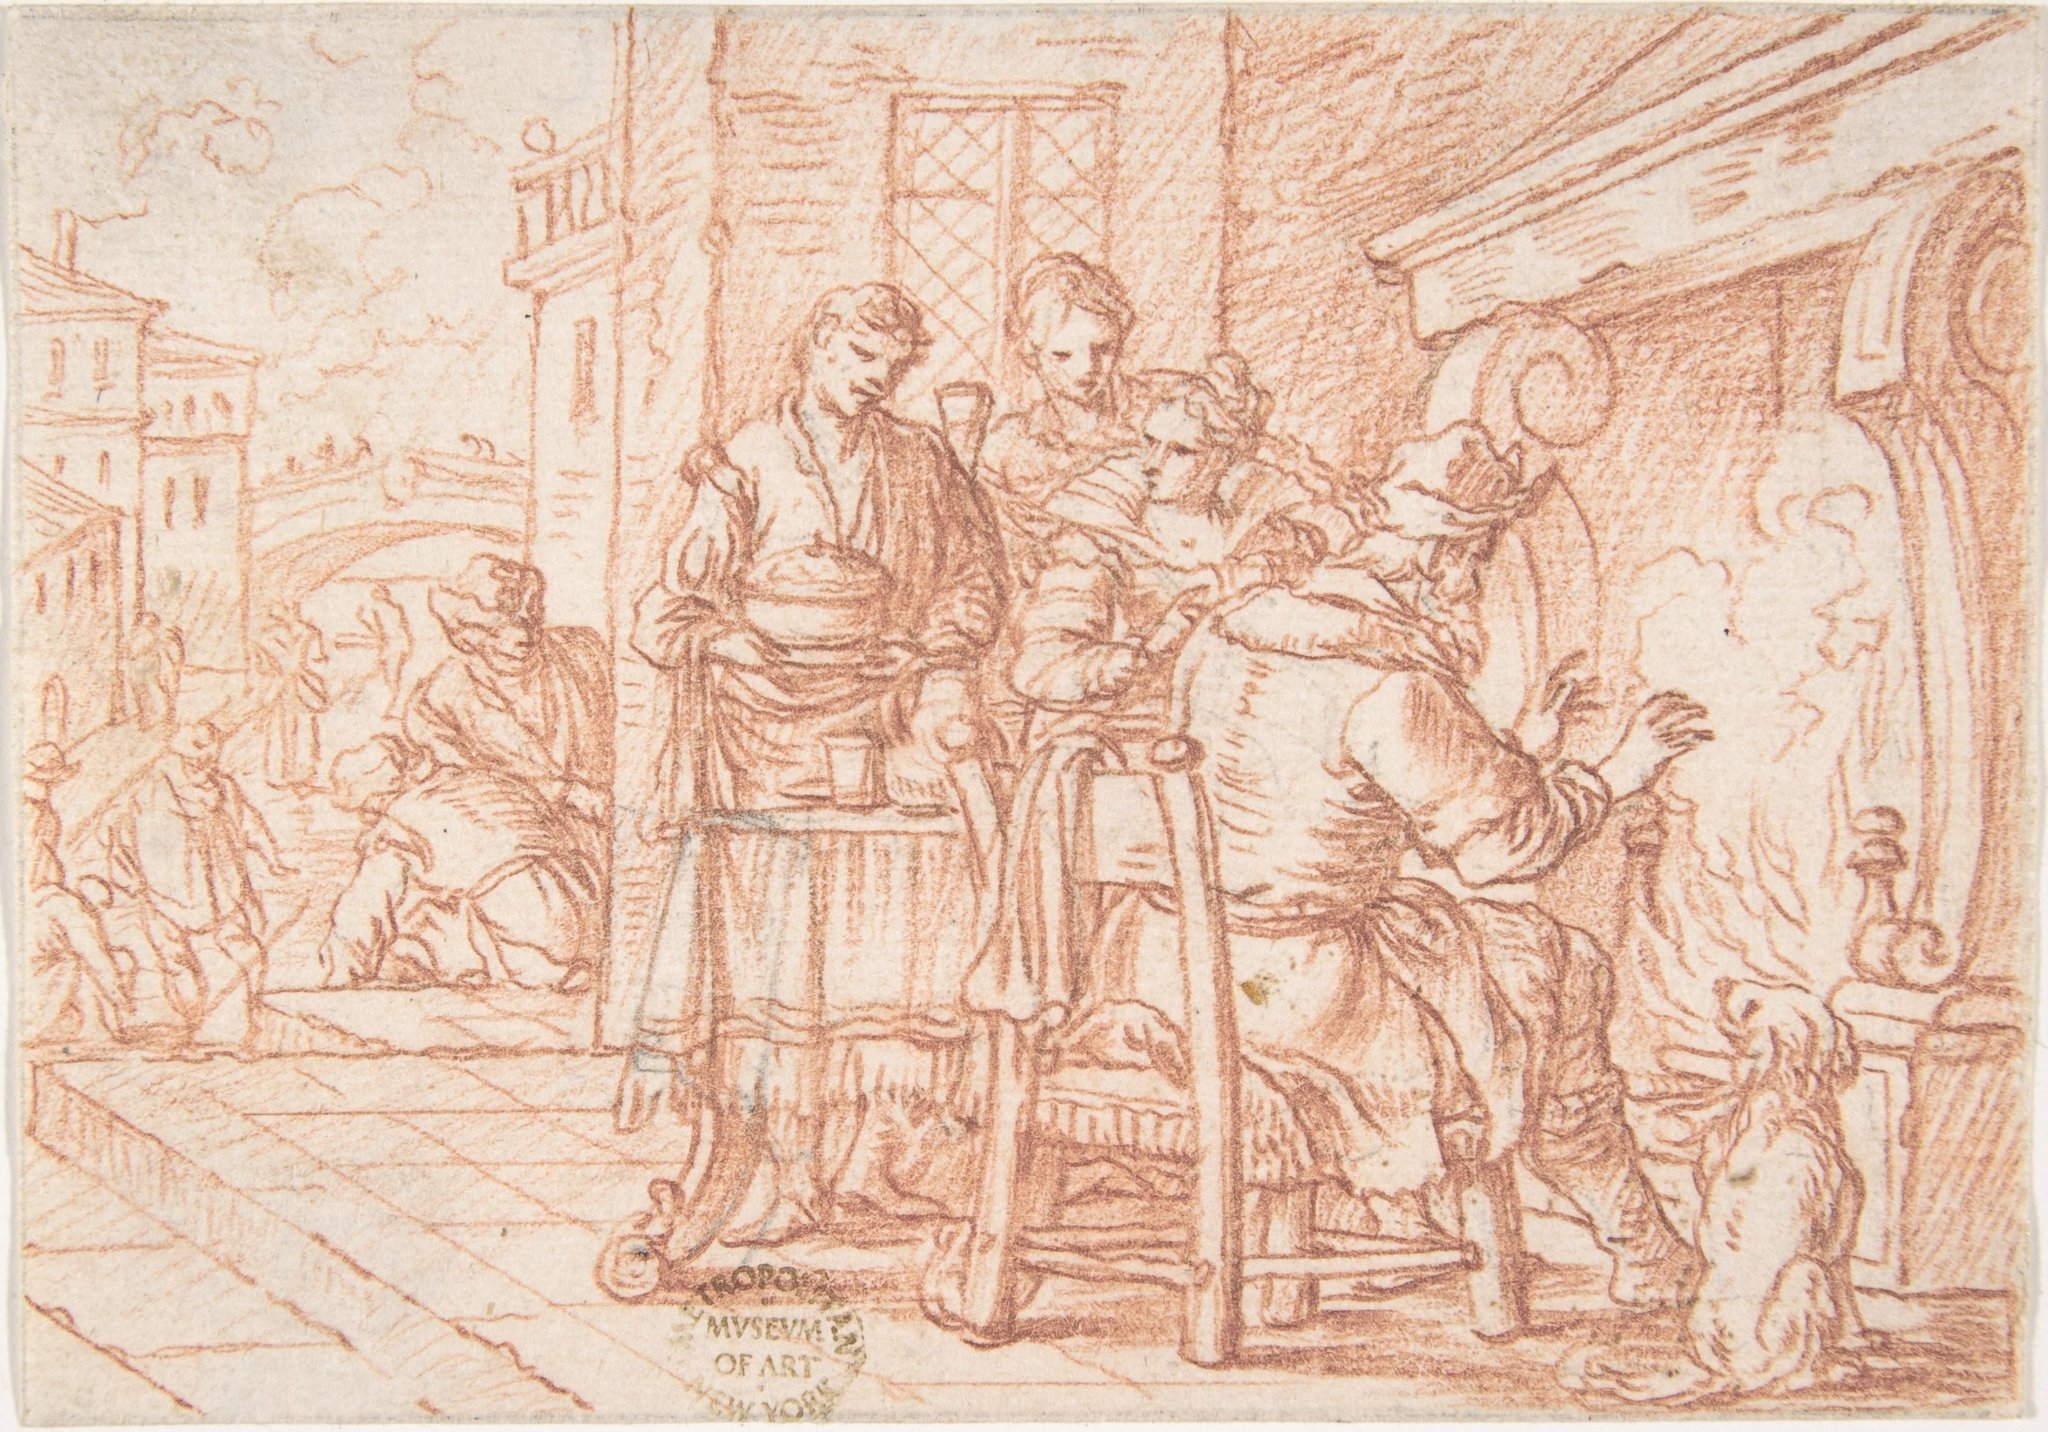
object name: drawing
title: January (one of a series representing the labors of the months)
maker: jonas umbach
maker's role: artist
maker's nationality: german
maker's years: 1624-1693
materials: chalk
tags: food,buildings,fireplaces,men,women,dogs,fire,winter,chairs